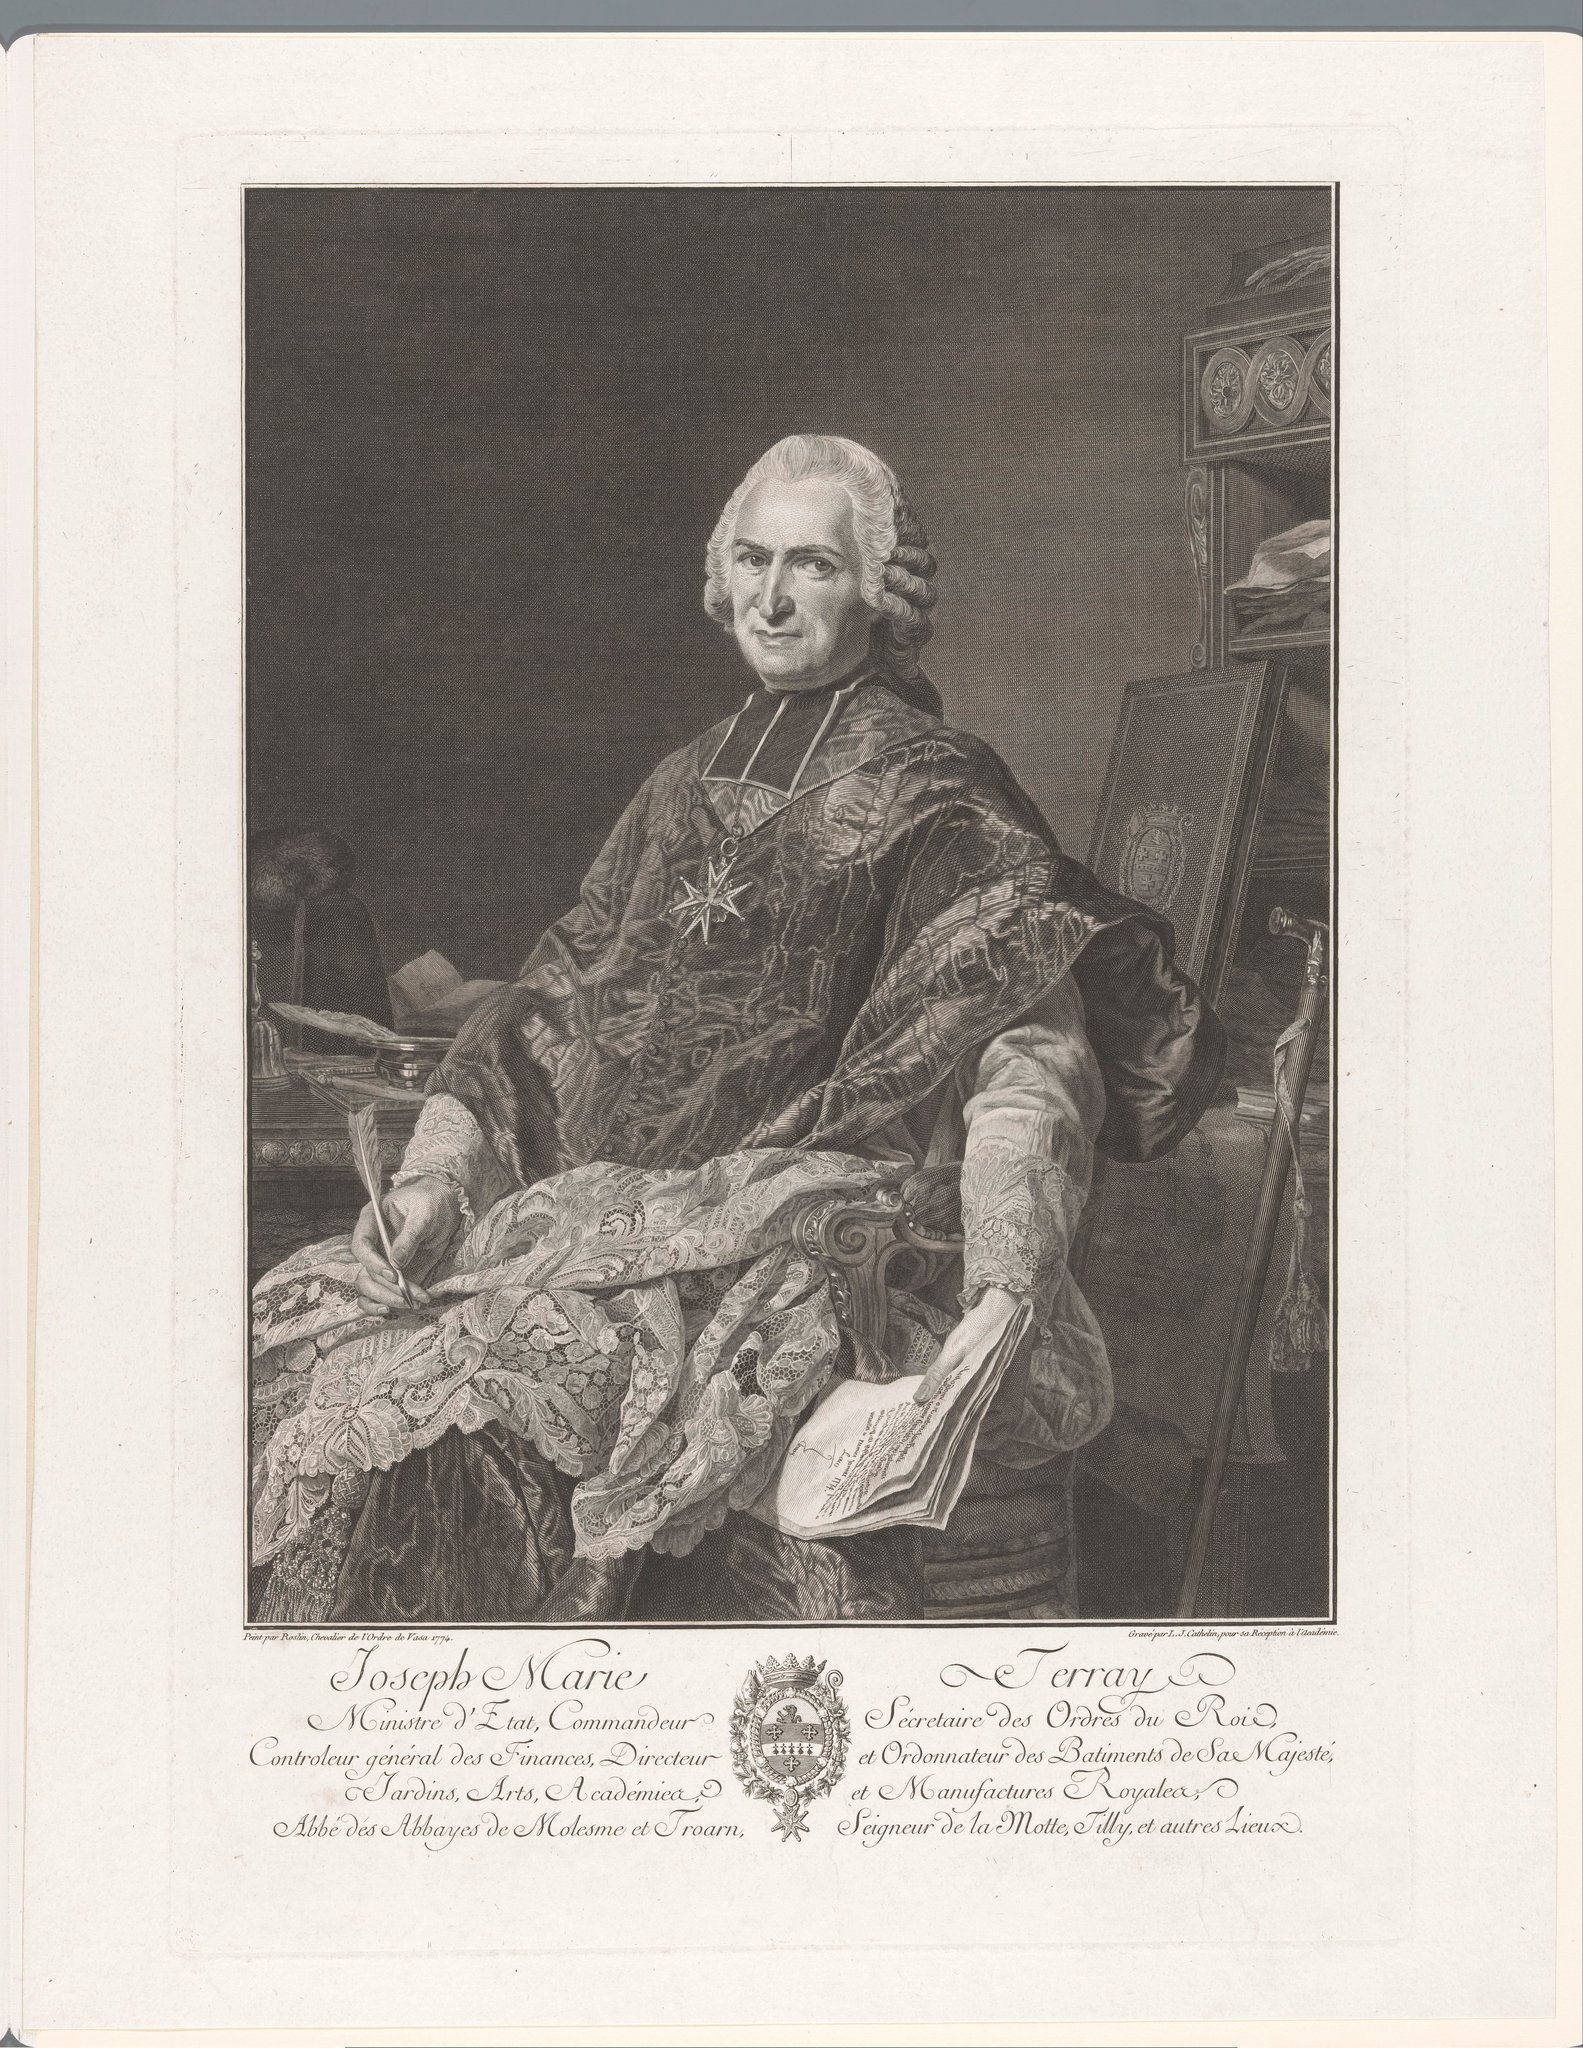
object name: print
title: Portret van Joseph Marie Terray aan een bureau met een pen en brief in zijn hand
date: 1774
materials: paper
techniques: engraving, etching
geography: france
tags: joseph marie terray, writing-table, writing-desk, minister ~ government, quill, historical persons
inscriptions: collector's mark: Lugt 2760, collector's mark: Lugt 2228